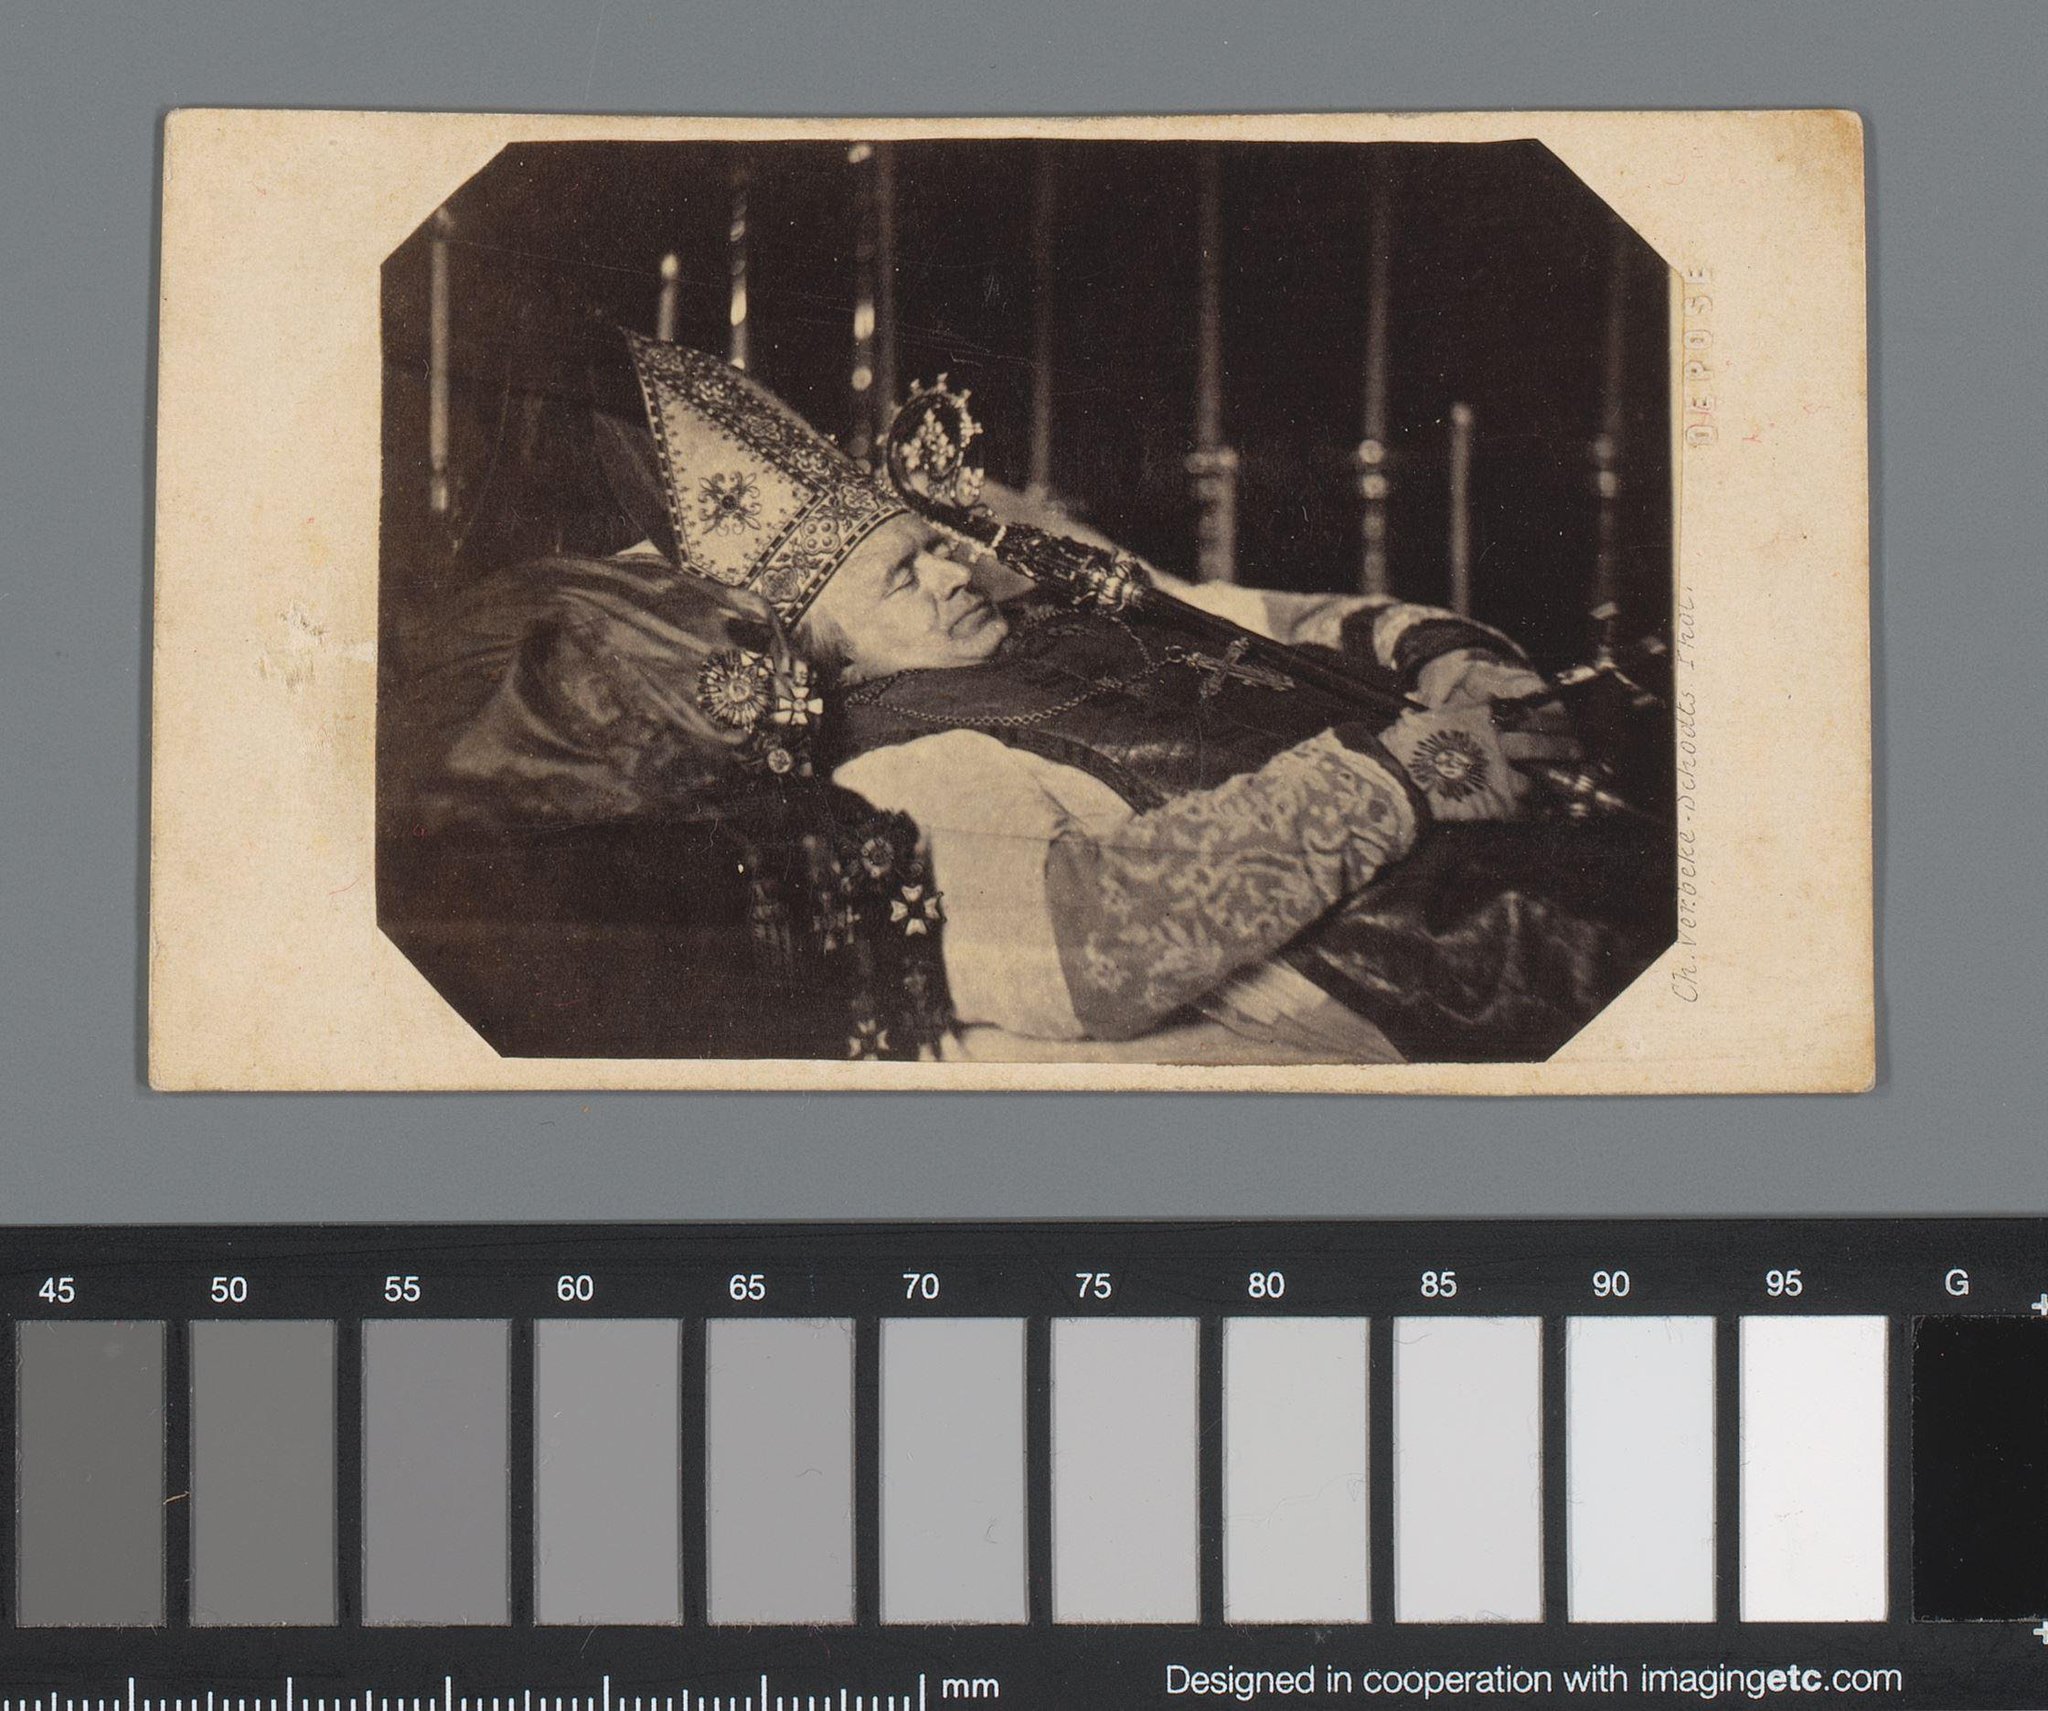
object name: carte de visite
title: Post-mortemportret van een onbekende bisschop gekleed in zijn staatsiegewaad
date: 1856-1876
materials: cardboard, paper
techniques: albumen print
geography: leuven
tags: archbishop, bishop, etc. (roman catholic), louvain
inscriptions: address: ‘rue de Bruxelles, 20/ LOUVAIN.’